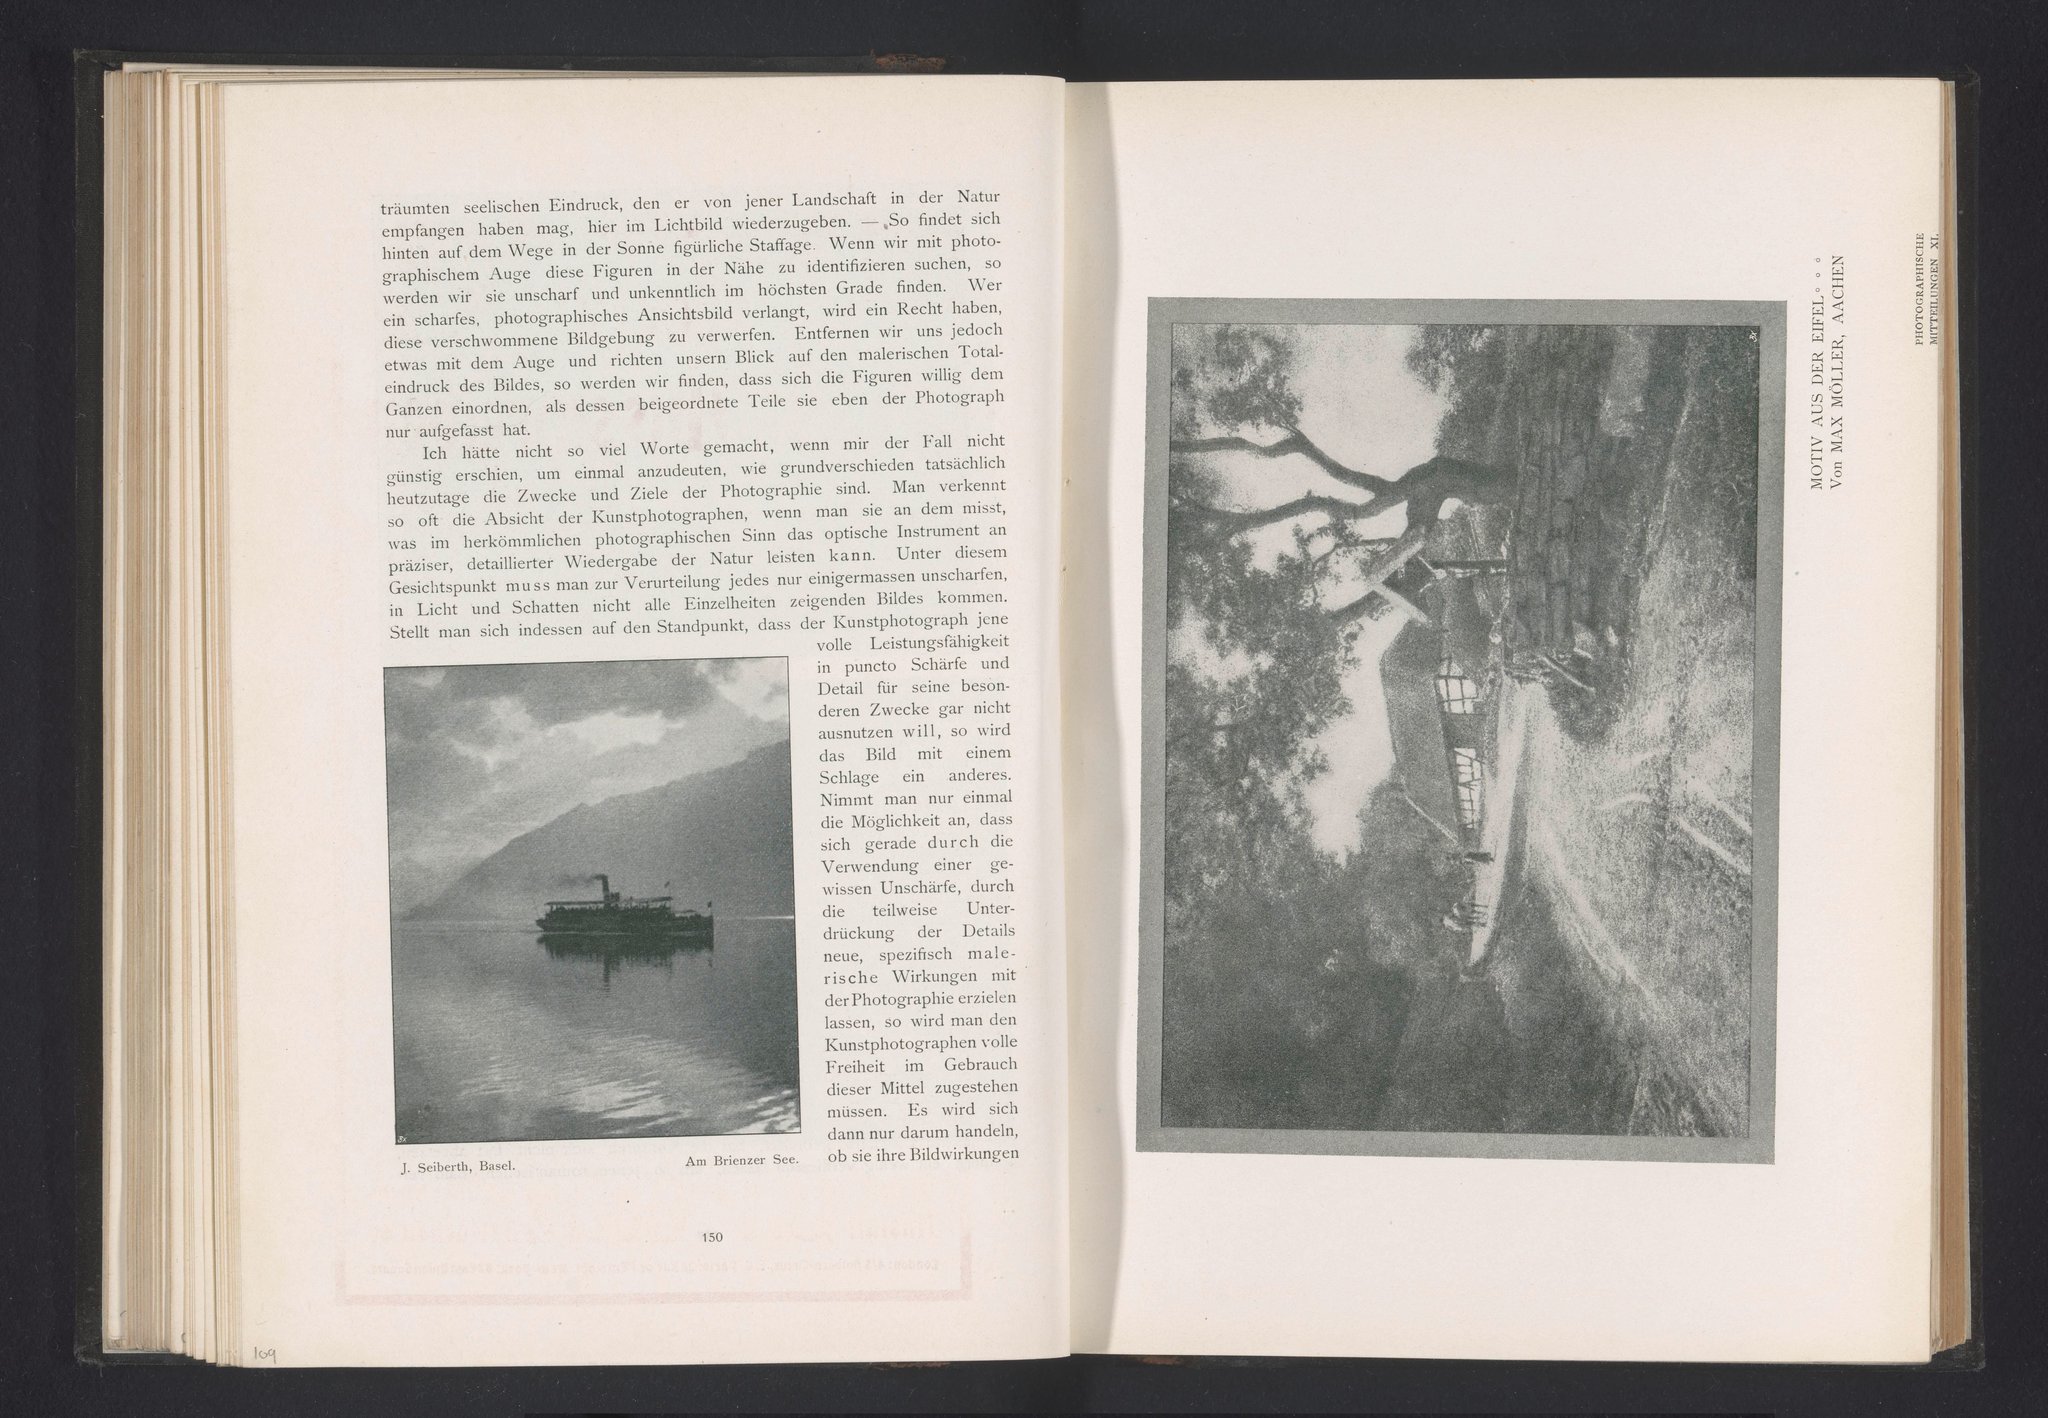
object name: photomechanical print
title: Gezicht op de Brienzersee met een stoomboot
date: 1898-1903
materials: paper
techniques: autotype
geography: lake brienz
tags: lake, covered wagon, hooded wagon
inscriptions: monogram: ‘BX’